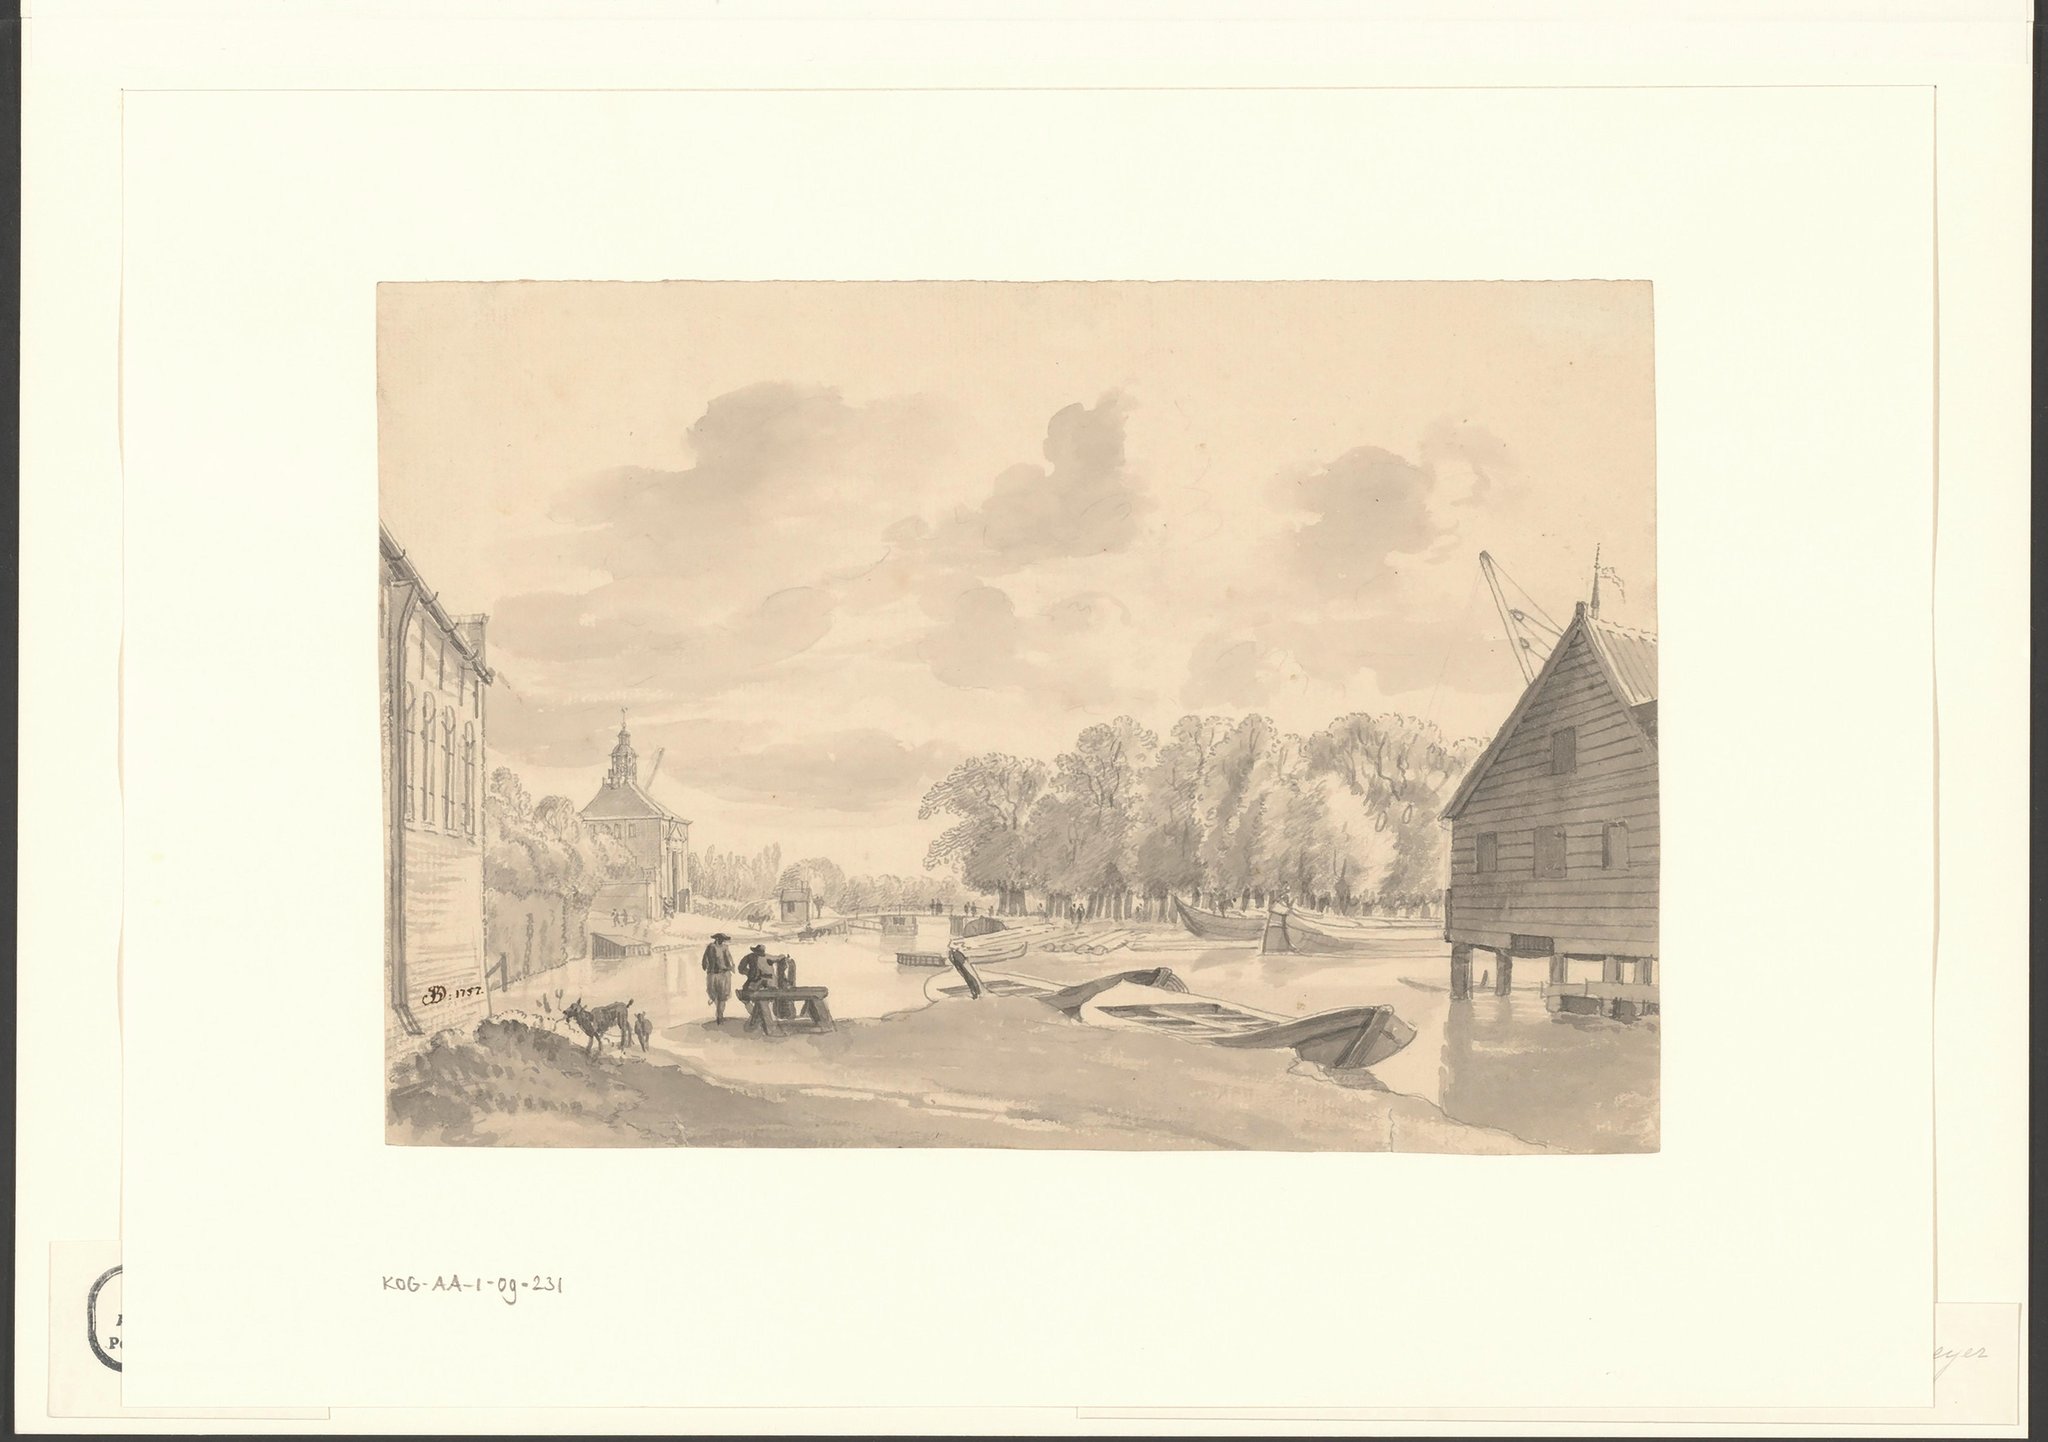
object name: drawing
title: Gezicht op de Plantage Muidergracht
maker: jan de beijer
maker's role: draughtsman, print maker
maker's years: 1703-1780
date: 1757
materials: ink, paper, pencil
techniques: brush, pen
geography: amsterdam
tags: city-view in general; 'veduta', canal, street, city-gate, boat propelled by man or animal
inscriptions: inscription: ‘nieuwe Lijnbaansgracht / J de Beyer’, signature and date: ‘JDB:1757.’, collector's mark: ‘9’ Lugt 1641b, inscription: ‘Port. 9-231’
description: Onderwerpsrubriek binnen de Atlas Amsterdam: 2e Laurierdwarsstraat (Vuile Weespad), Leidschegracht, Leidschekade, Leidscheplein, Leidschestraat, v. Lennepkade, Lijnbaansgracht, Lauriergracht, Leliedwarsstraat, Leliegracht, Lindengracht, Lombardsteeg, Looiersgracht, Looiersstraat (Nieuwe), Leidekkerssteeg.